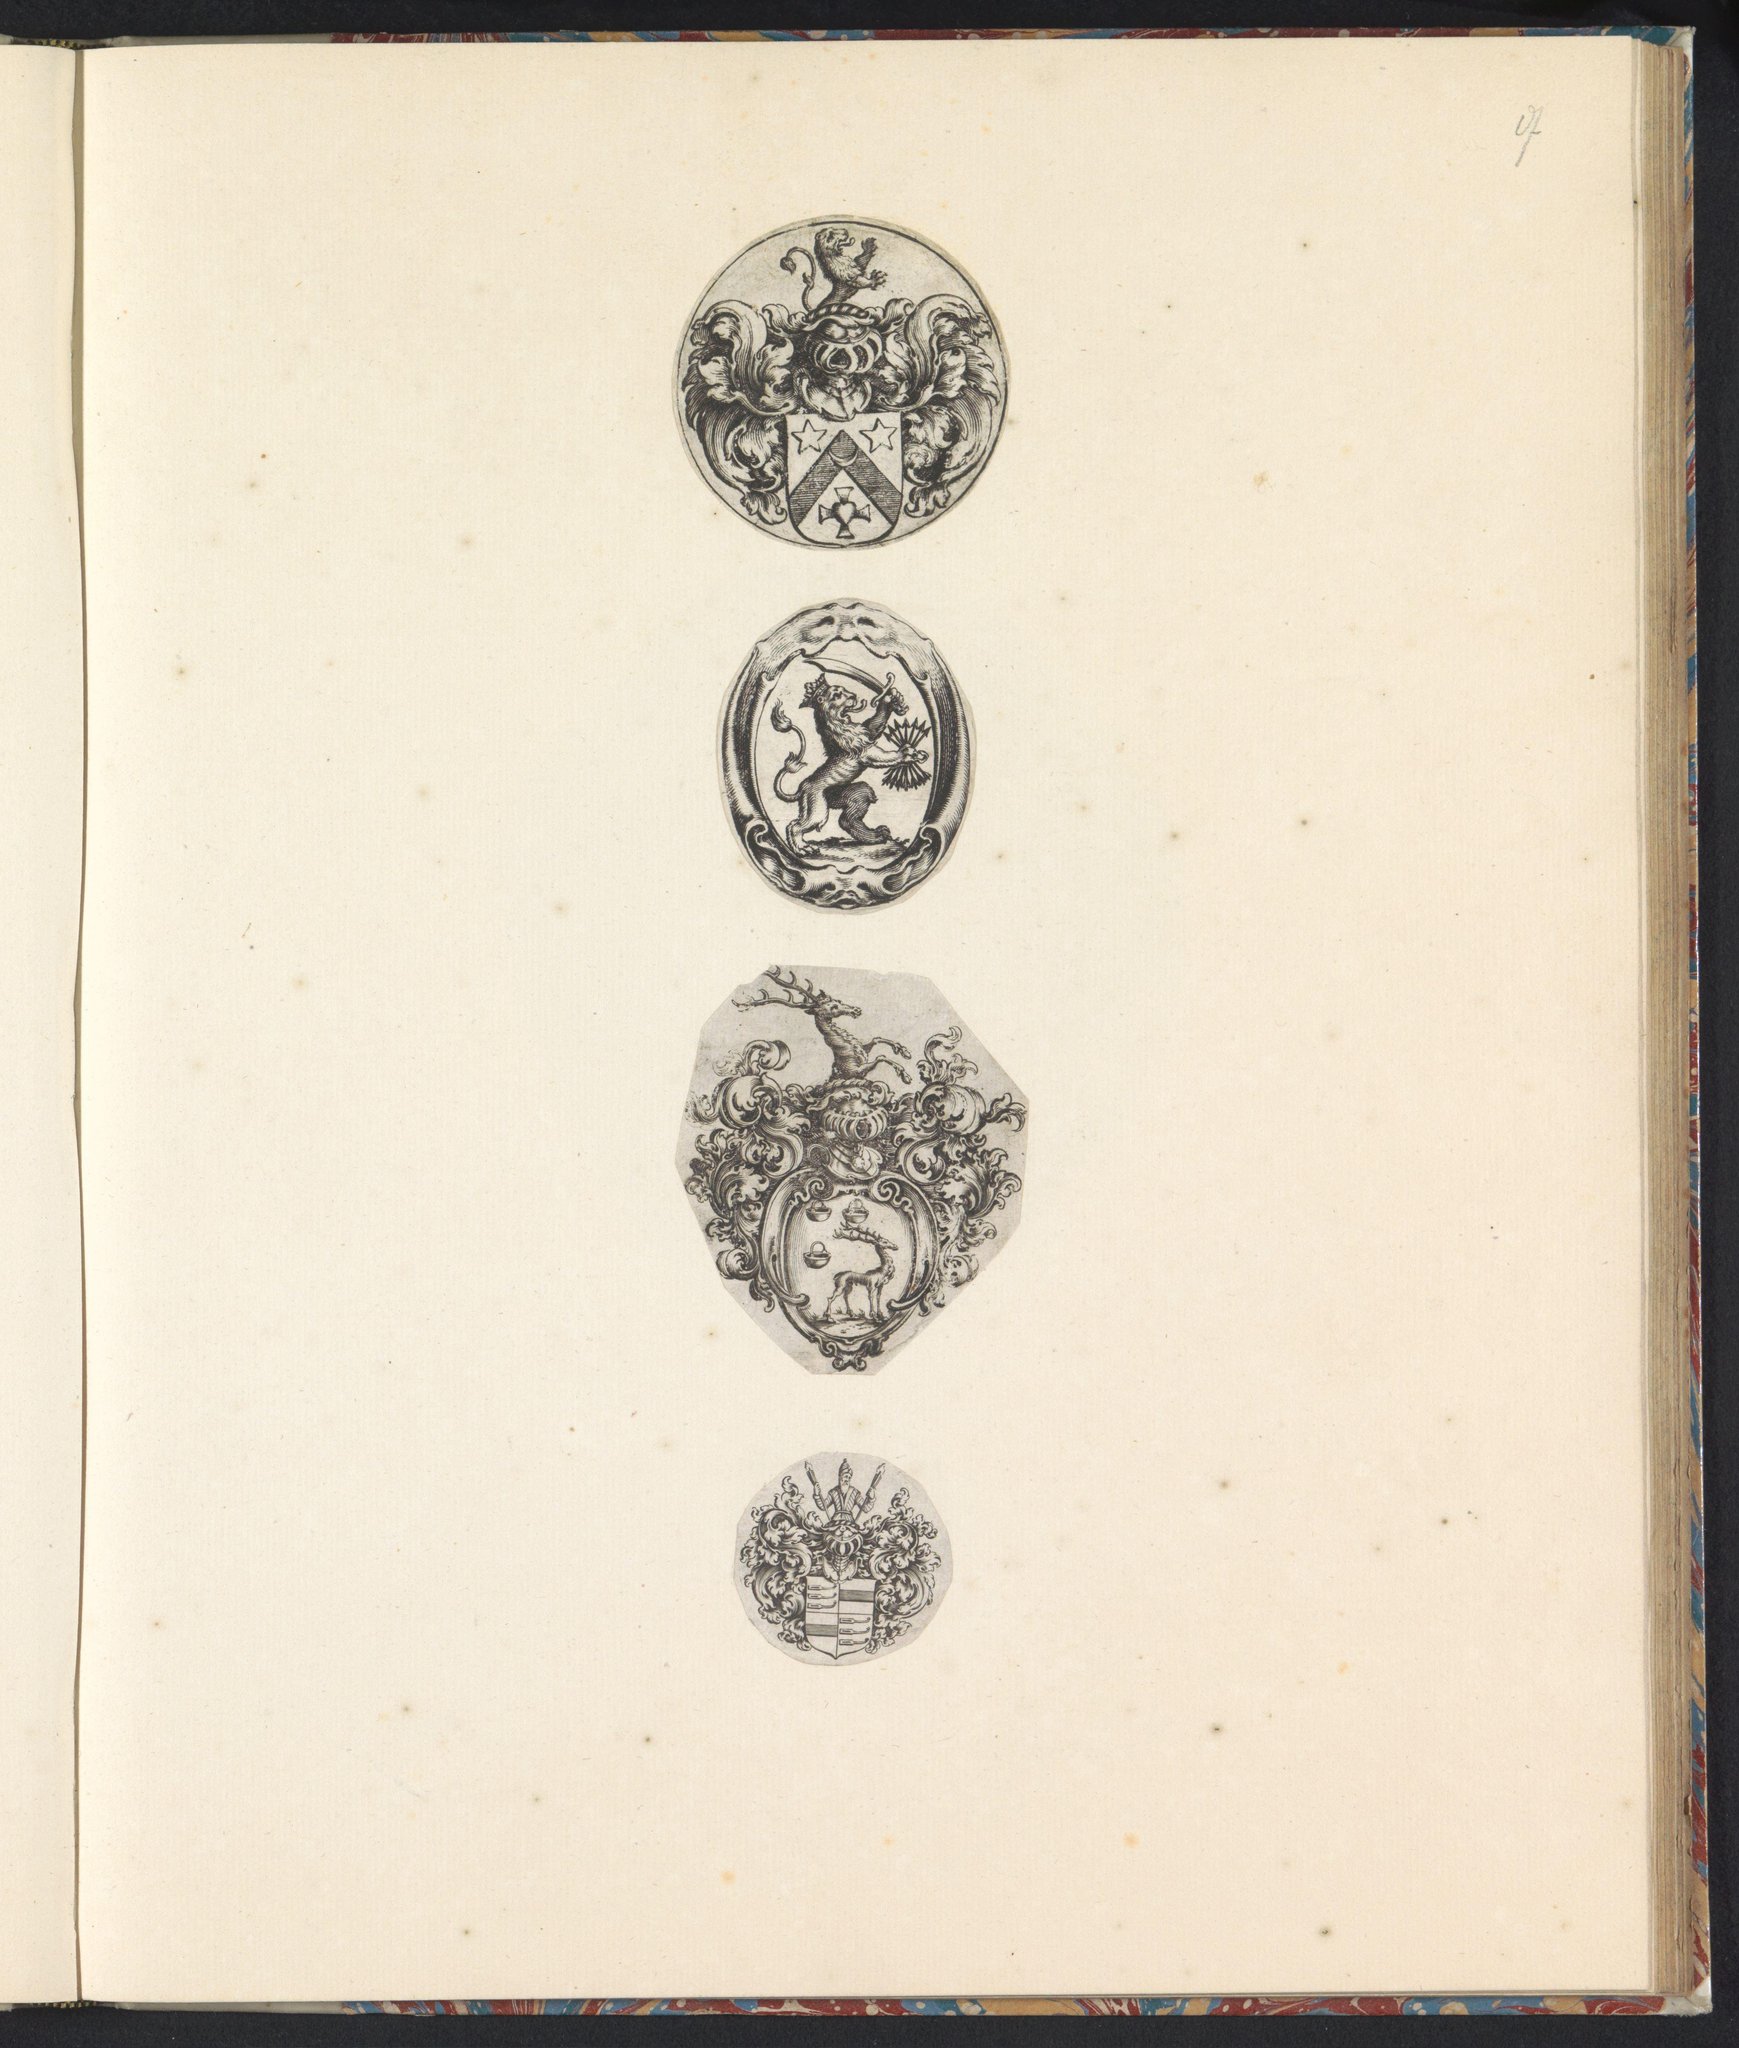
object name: print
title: Vier wapens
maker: Anonymous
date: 1600-1699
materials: paper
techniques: engraving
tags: armorial bearing, heraldry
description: Vier voorstellingen op een albumblad. Het gaat om vier wapens. Als tweede het wapen van de Republiek der Zeven Verenigde Nederlanden. Onderaan het wapen van de familie Bicker. De prenten maken deel uit van een album.